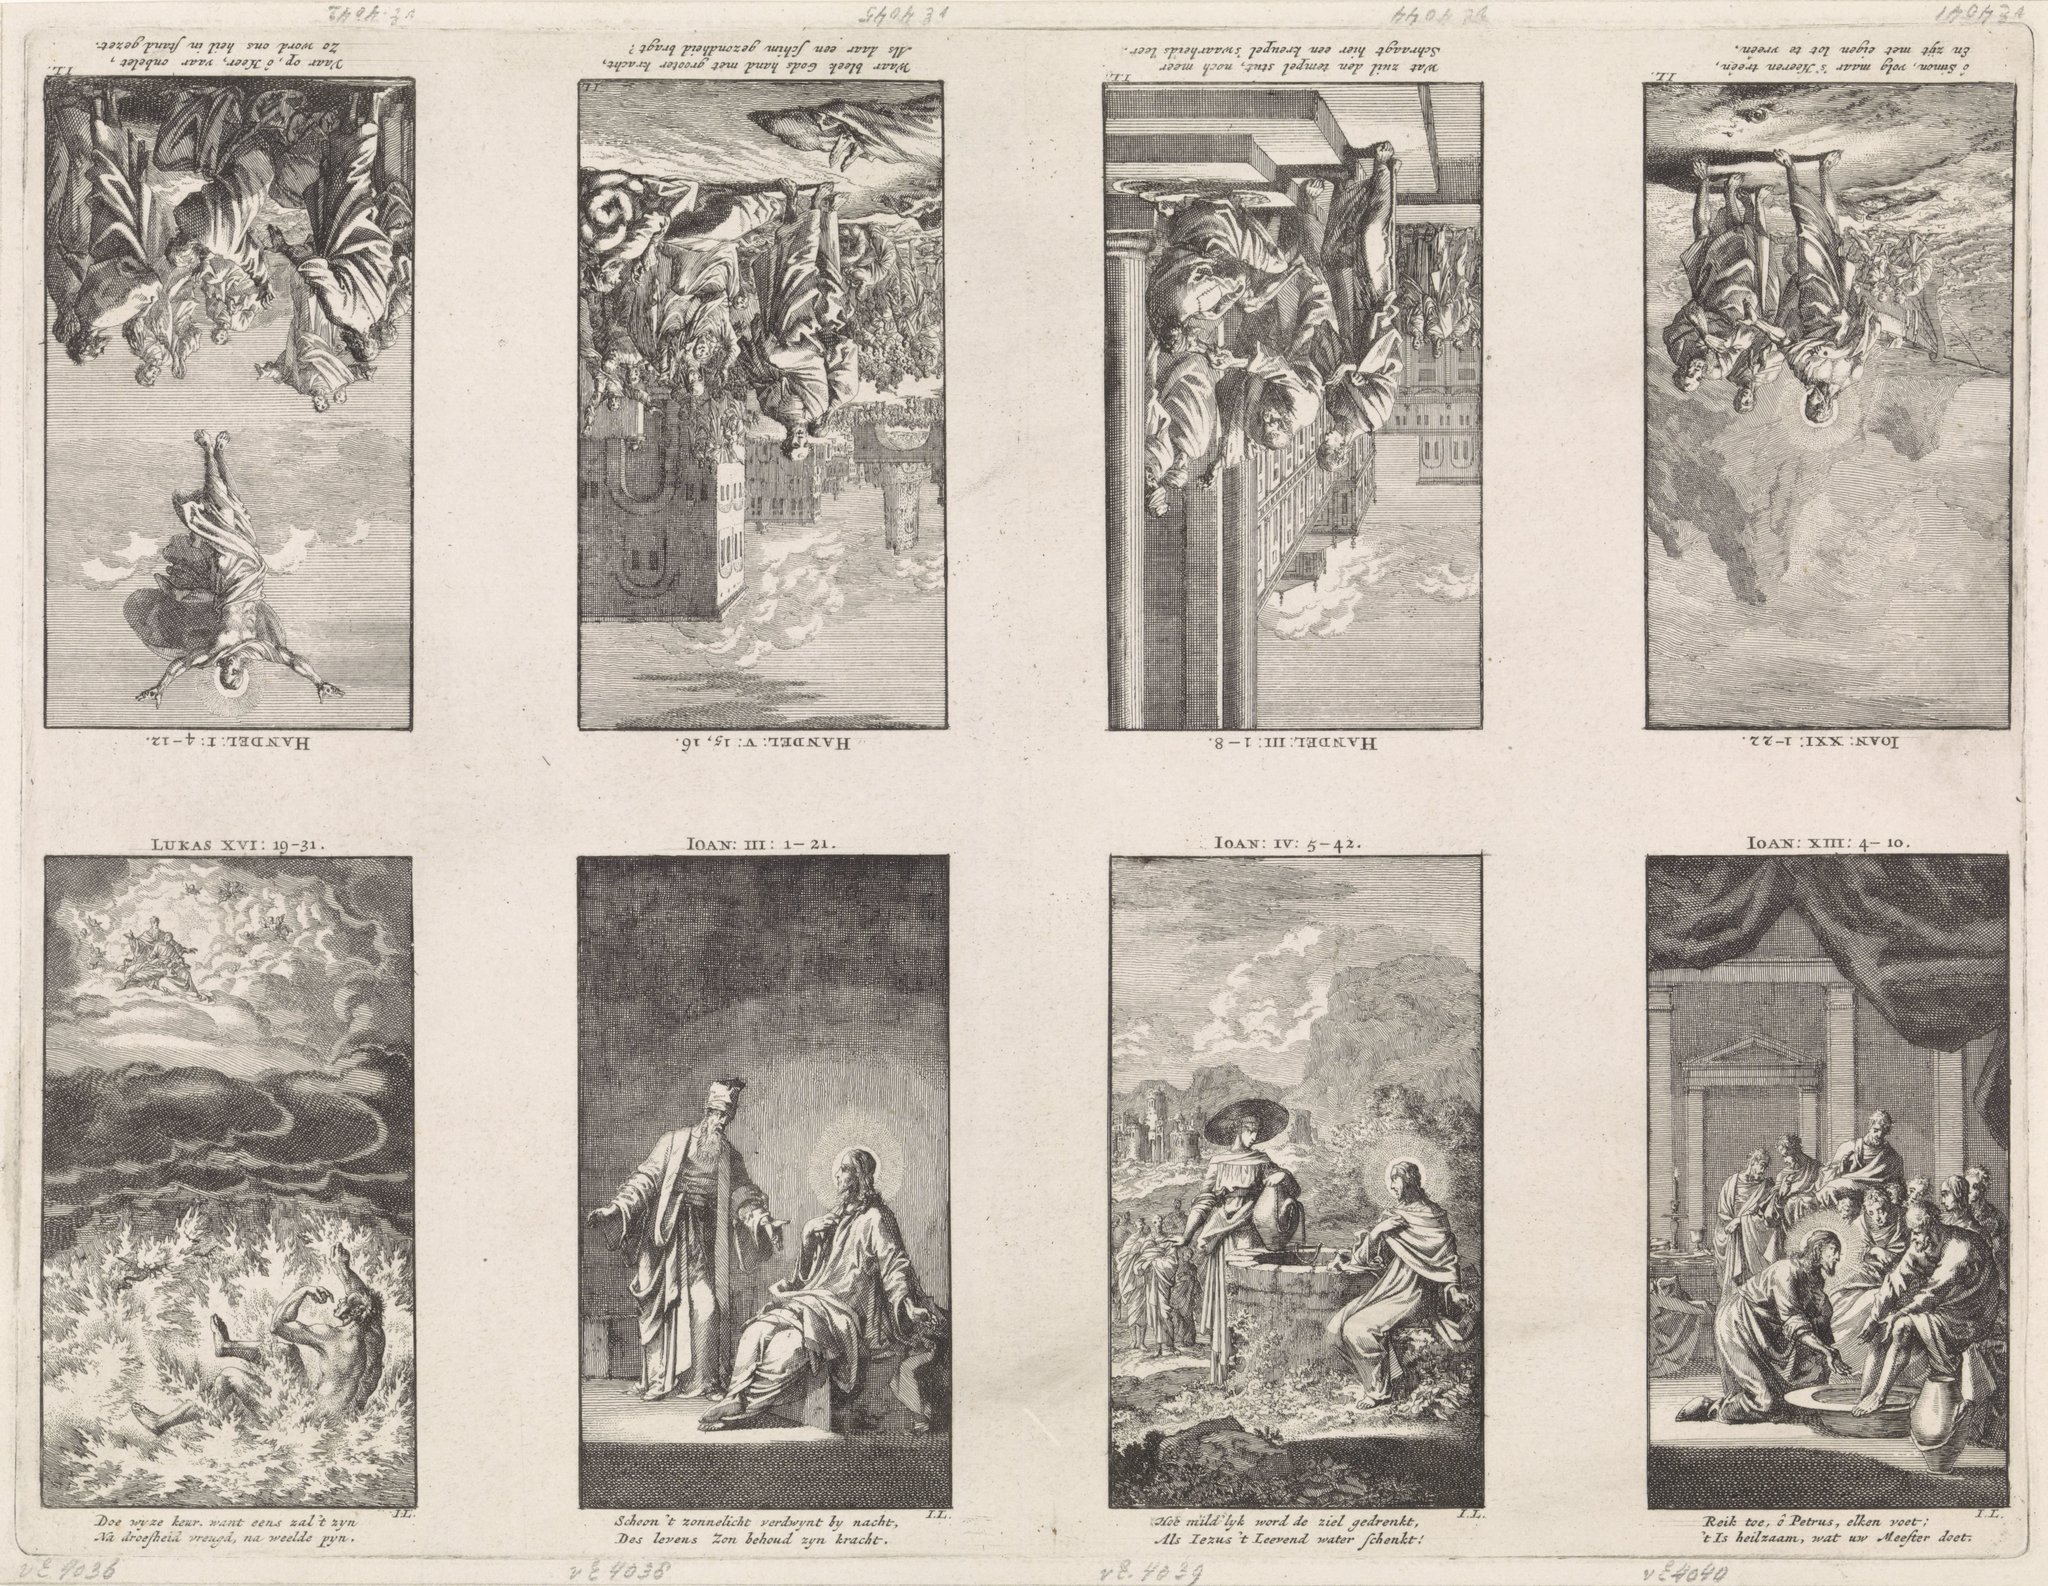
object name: print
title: Acht Nieuw Testamentische scènes op een blad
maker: jan luyken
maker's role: draughtsman, print maker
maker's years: 1649-1712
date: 1712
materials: paper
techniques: etching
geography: amsterdam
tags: christ and the woman of samaria: sitting at jacob's well he asks her for a drink from her jug, the ascension (christ surrounded by radiant light or in a mandorla), christ washes peter's feet, christ talking with nicodemus at night (john 3:1-21), healing of a lame beggar at the beautiful gate of the temple by peter and john (acts 3 - 4:31), appearance of christ at the lake of gennesaret (sea of galilee, sea of tiberias): miraculous draught of fishes (after the resurrection), the rich man (dives) is feasting, while poor lazarus is starving at the gate (dogs licking lazarus' sores) (luke 16:19-31), a multitude of the sick healed by peter and other disciples (acts 5:12-16)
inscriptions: collector's mark: Lugt 2228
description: Proefdruk van illustratie voor: Luyken, Jan. Bybel printen. Amsterdam: Pieter Arentsz. II (wed.) en Cornelis van der Sys, 1712.